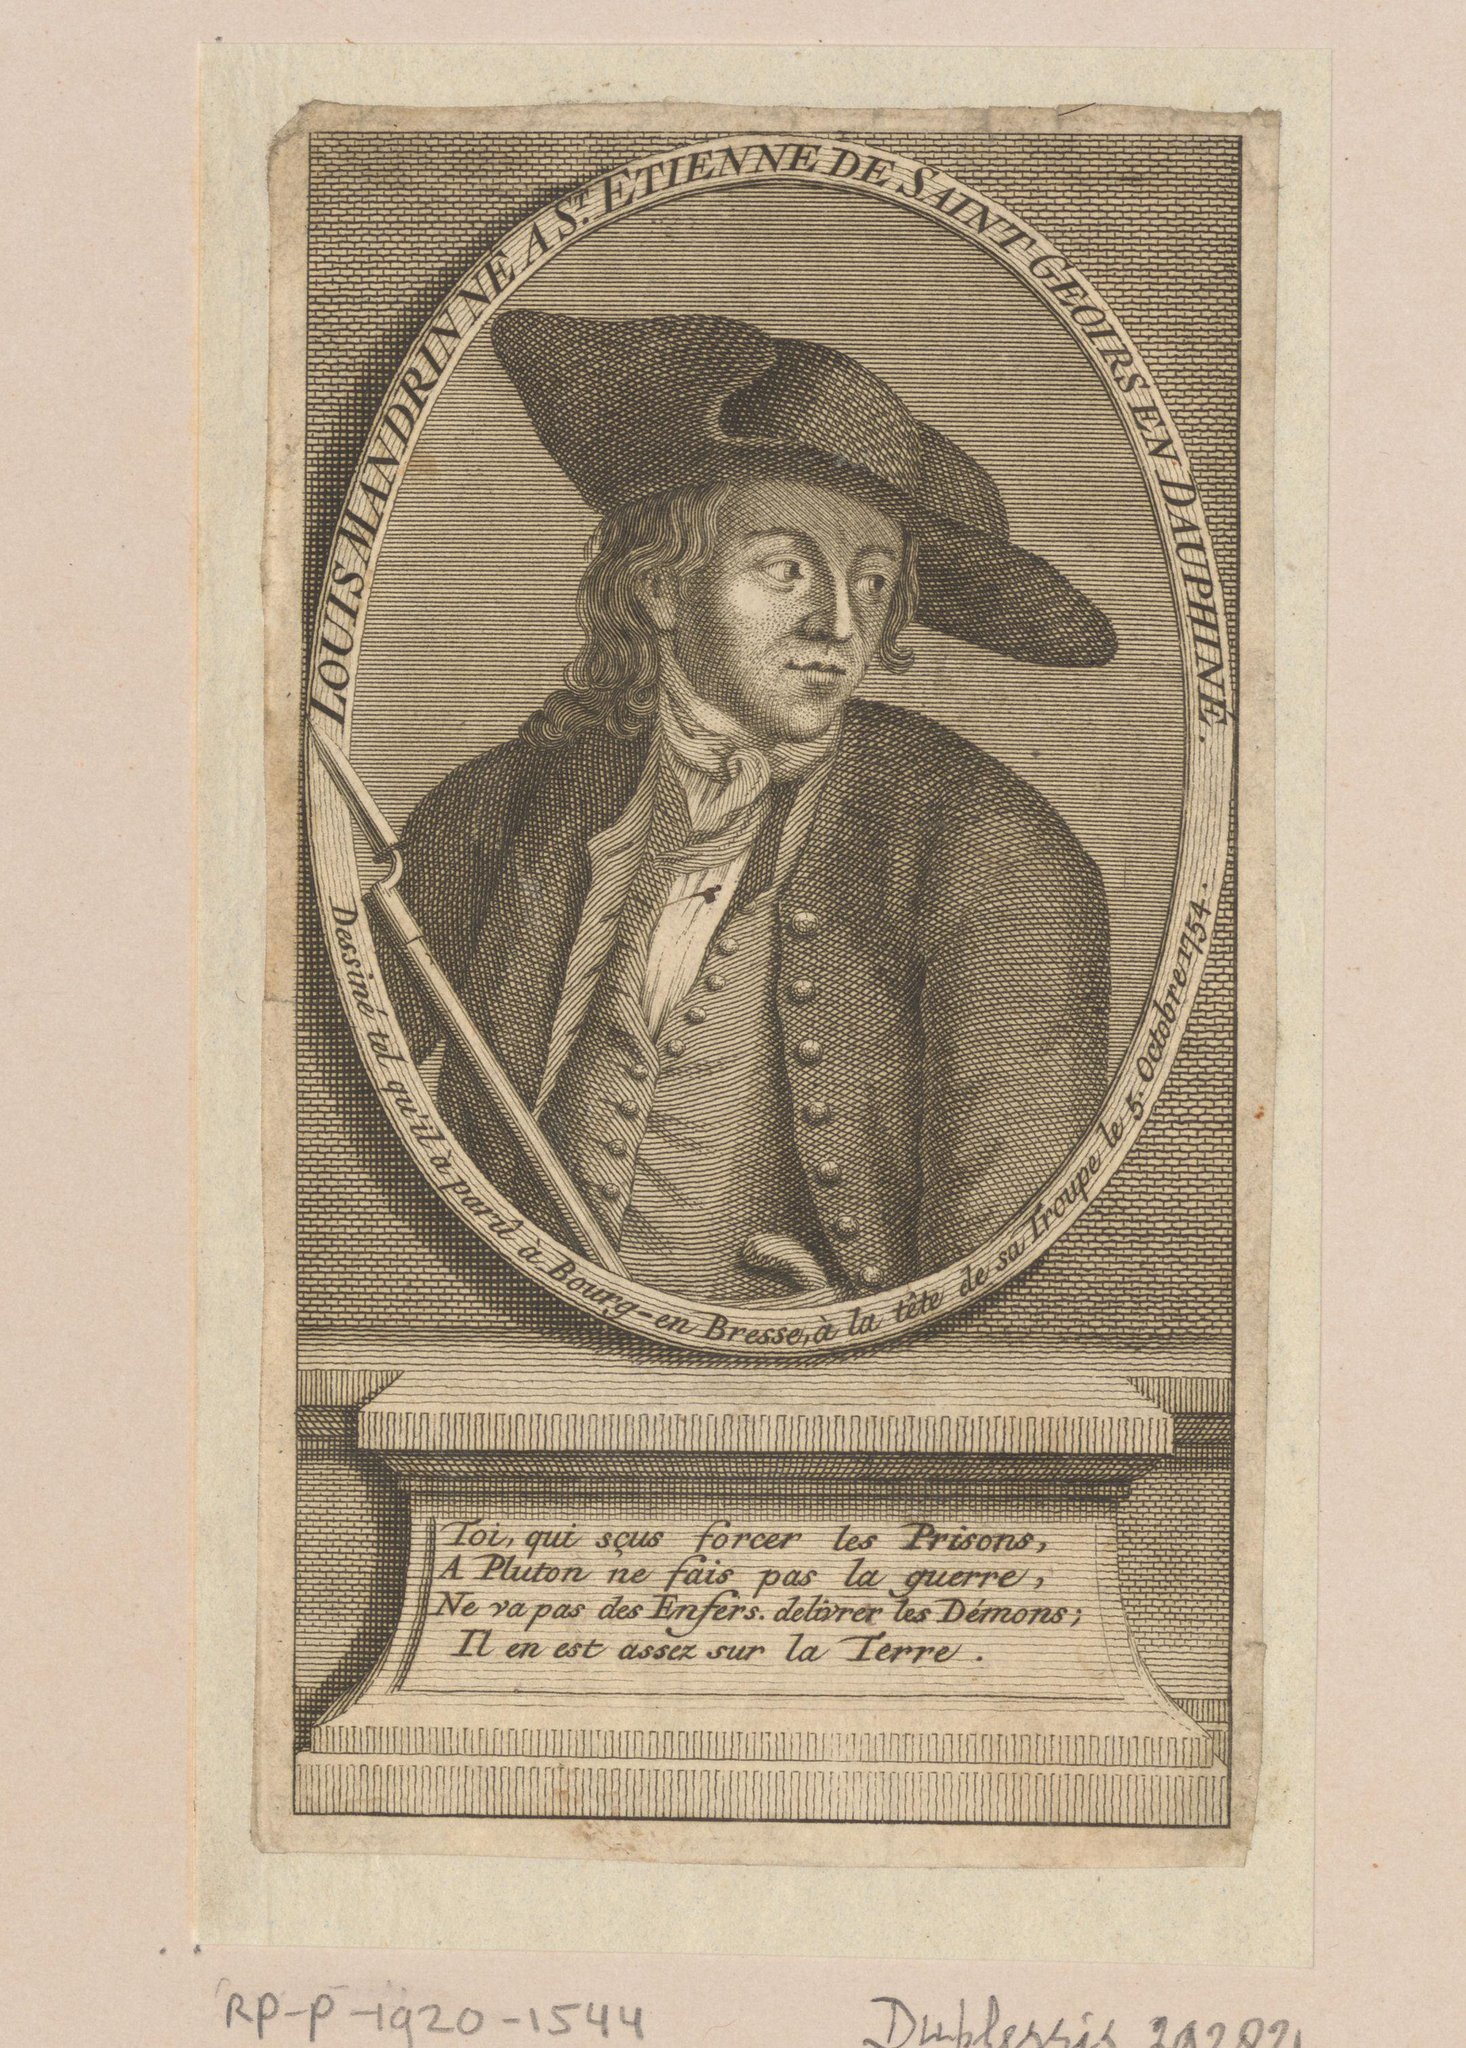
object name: print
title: Portret van Louis Mandrin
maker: Anonymous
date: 1754-1799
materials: paper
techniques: etching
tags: ornament ~ medallion, historical persons, smuggler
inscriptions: collector's mark: Lugt 2228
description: Met vierregelig vers in het Frans onder het portret.